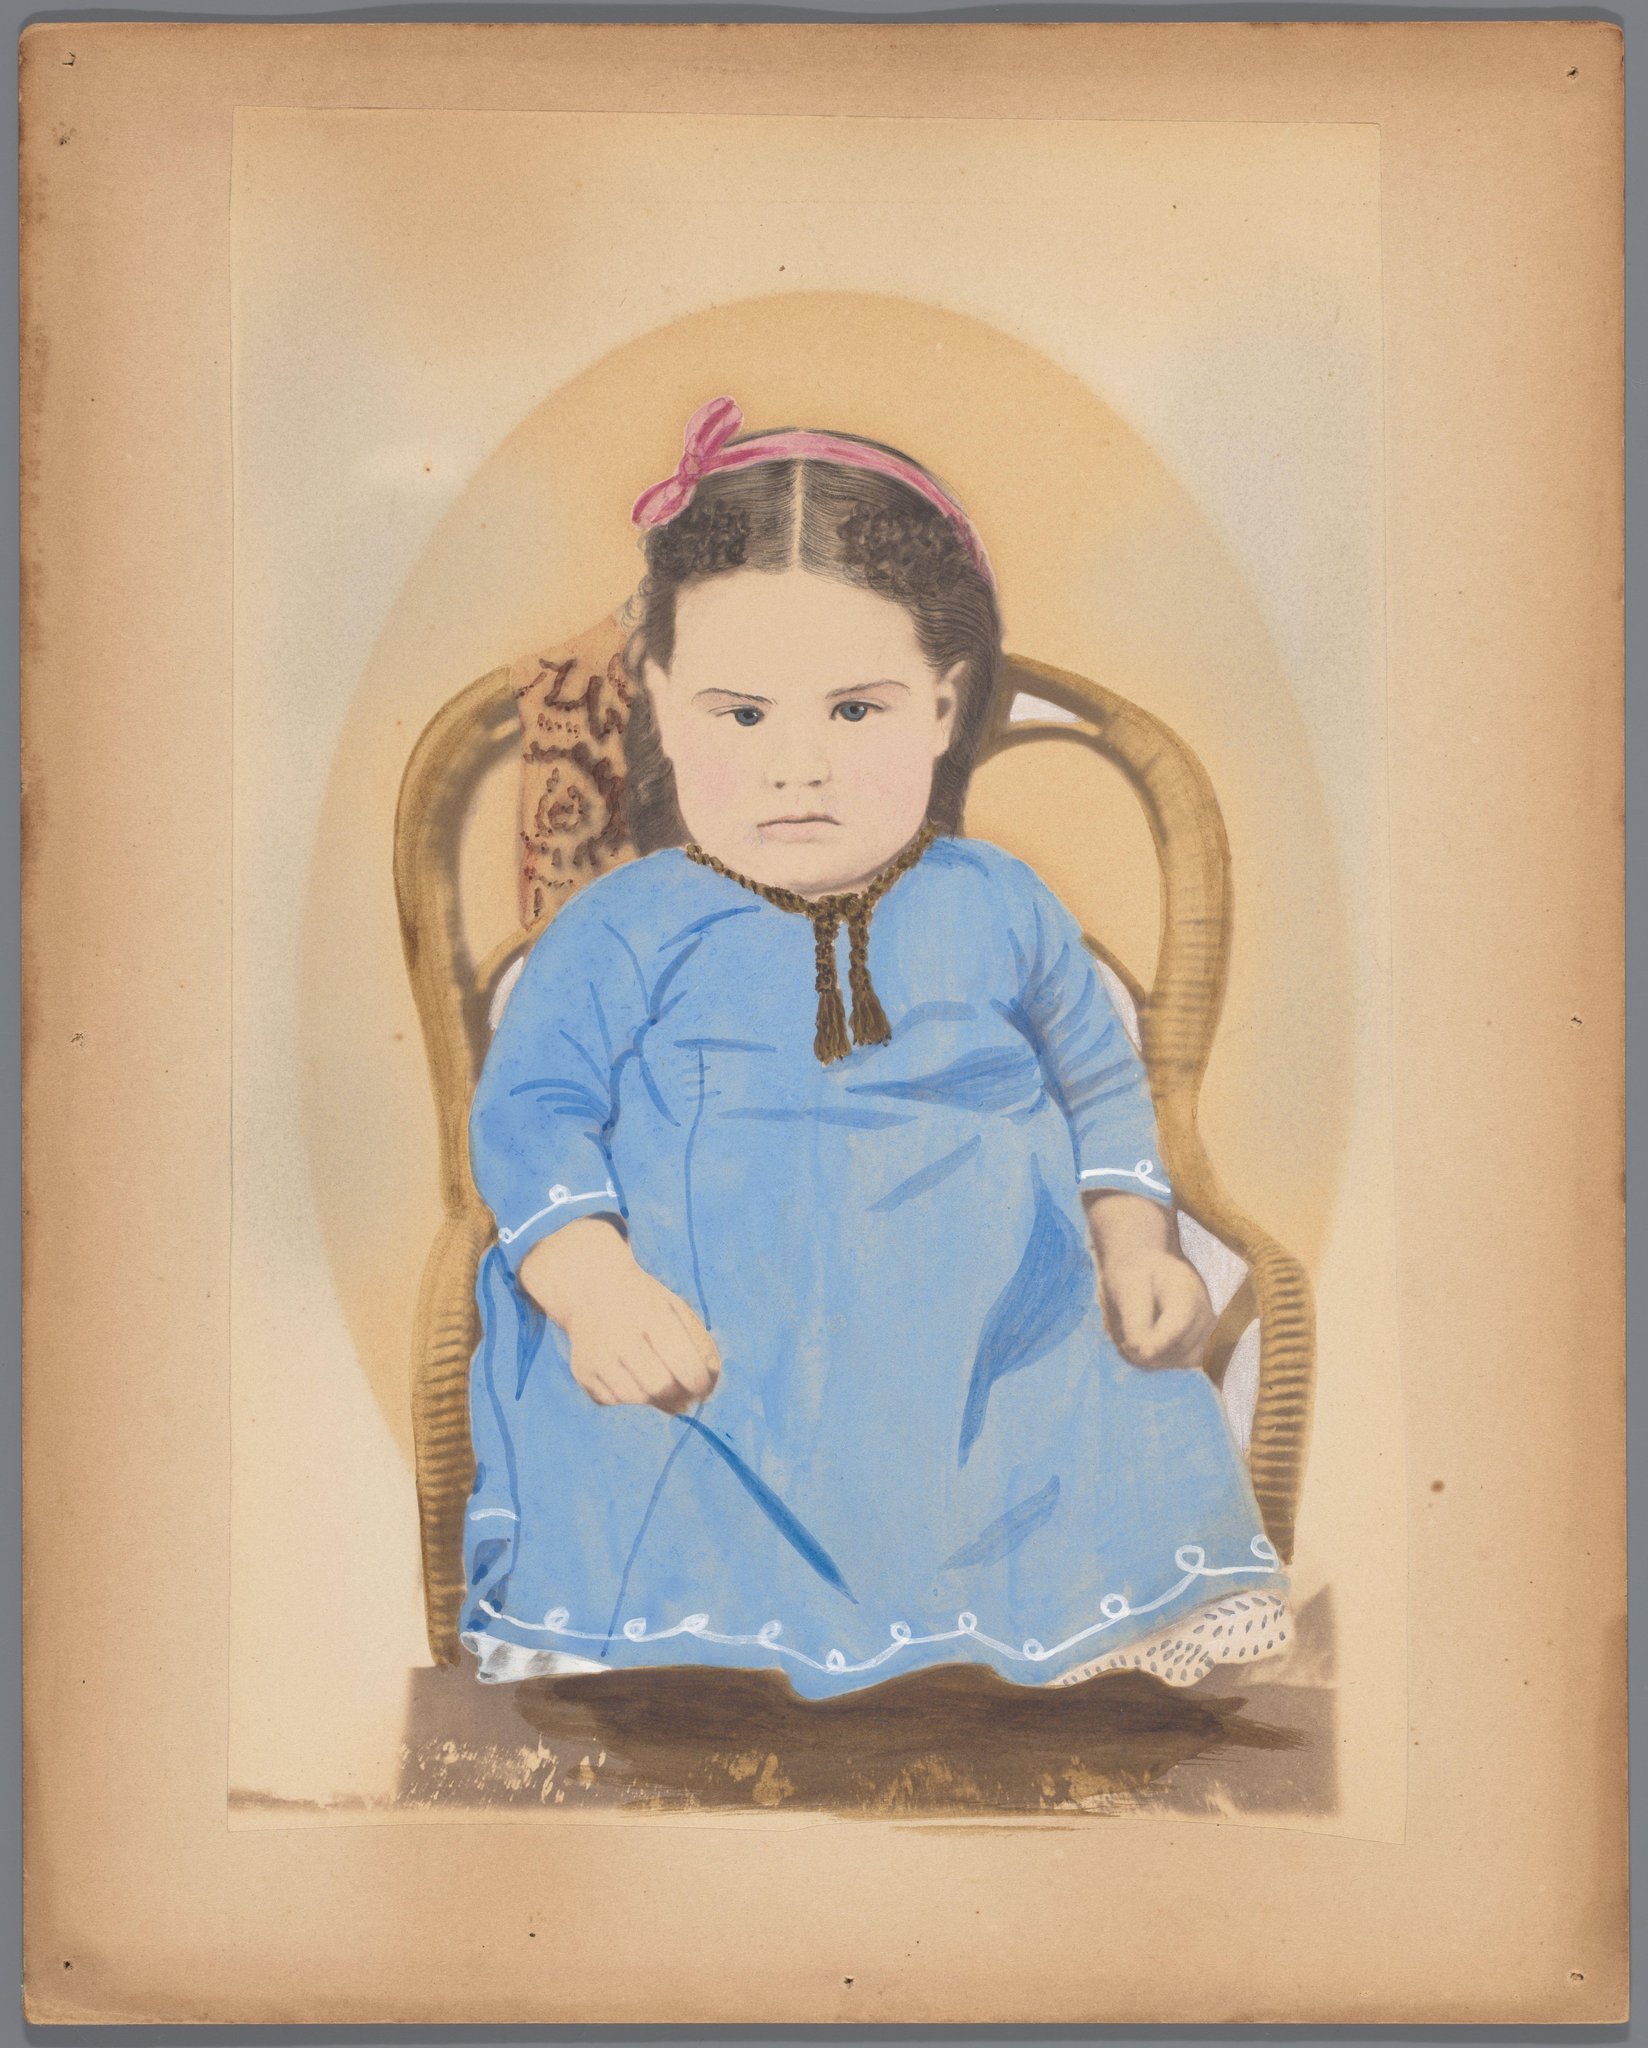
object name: photograph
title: Portret van een kind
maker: Anonymous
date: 1850-1860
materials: photographic support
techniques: salted paper print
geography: united states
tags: girl (child between toddler and youth), anonymous historical person portrayed - bb - woman